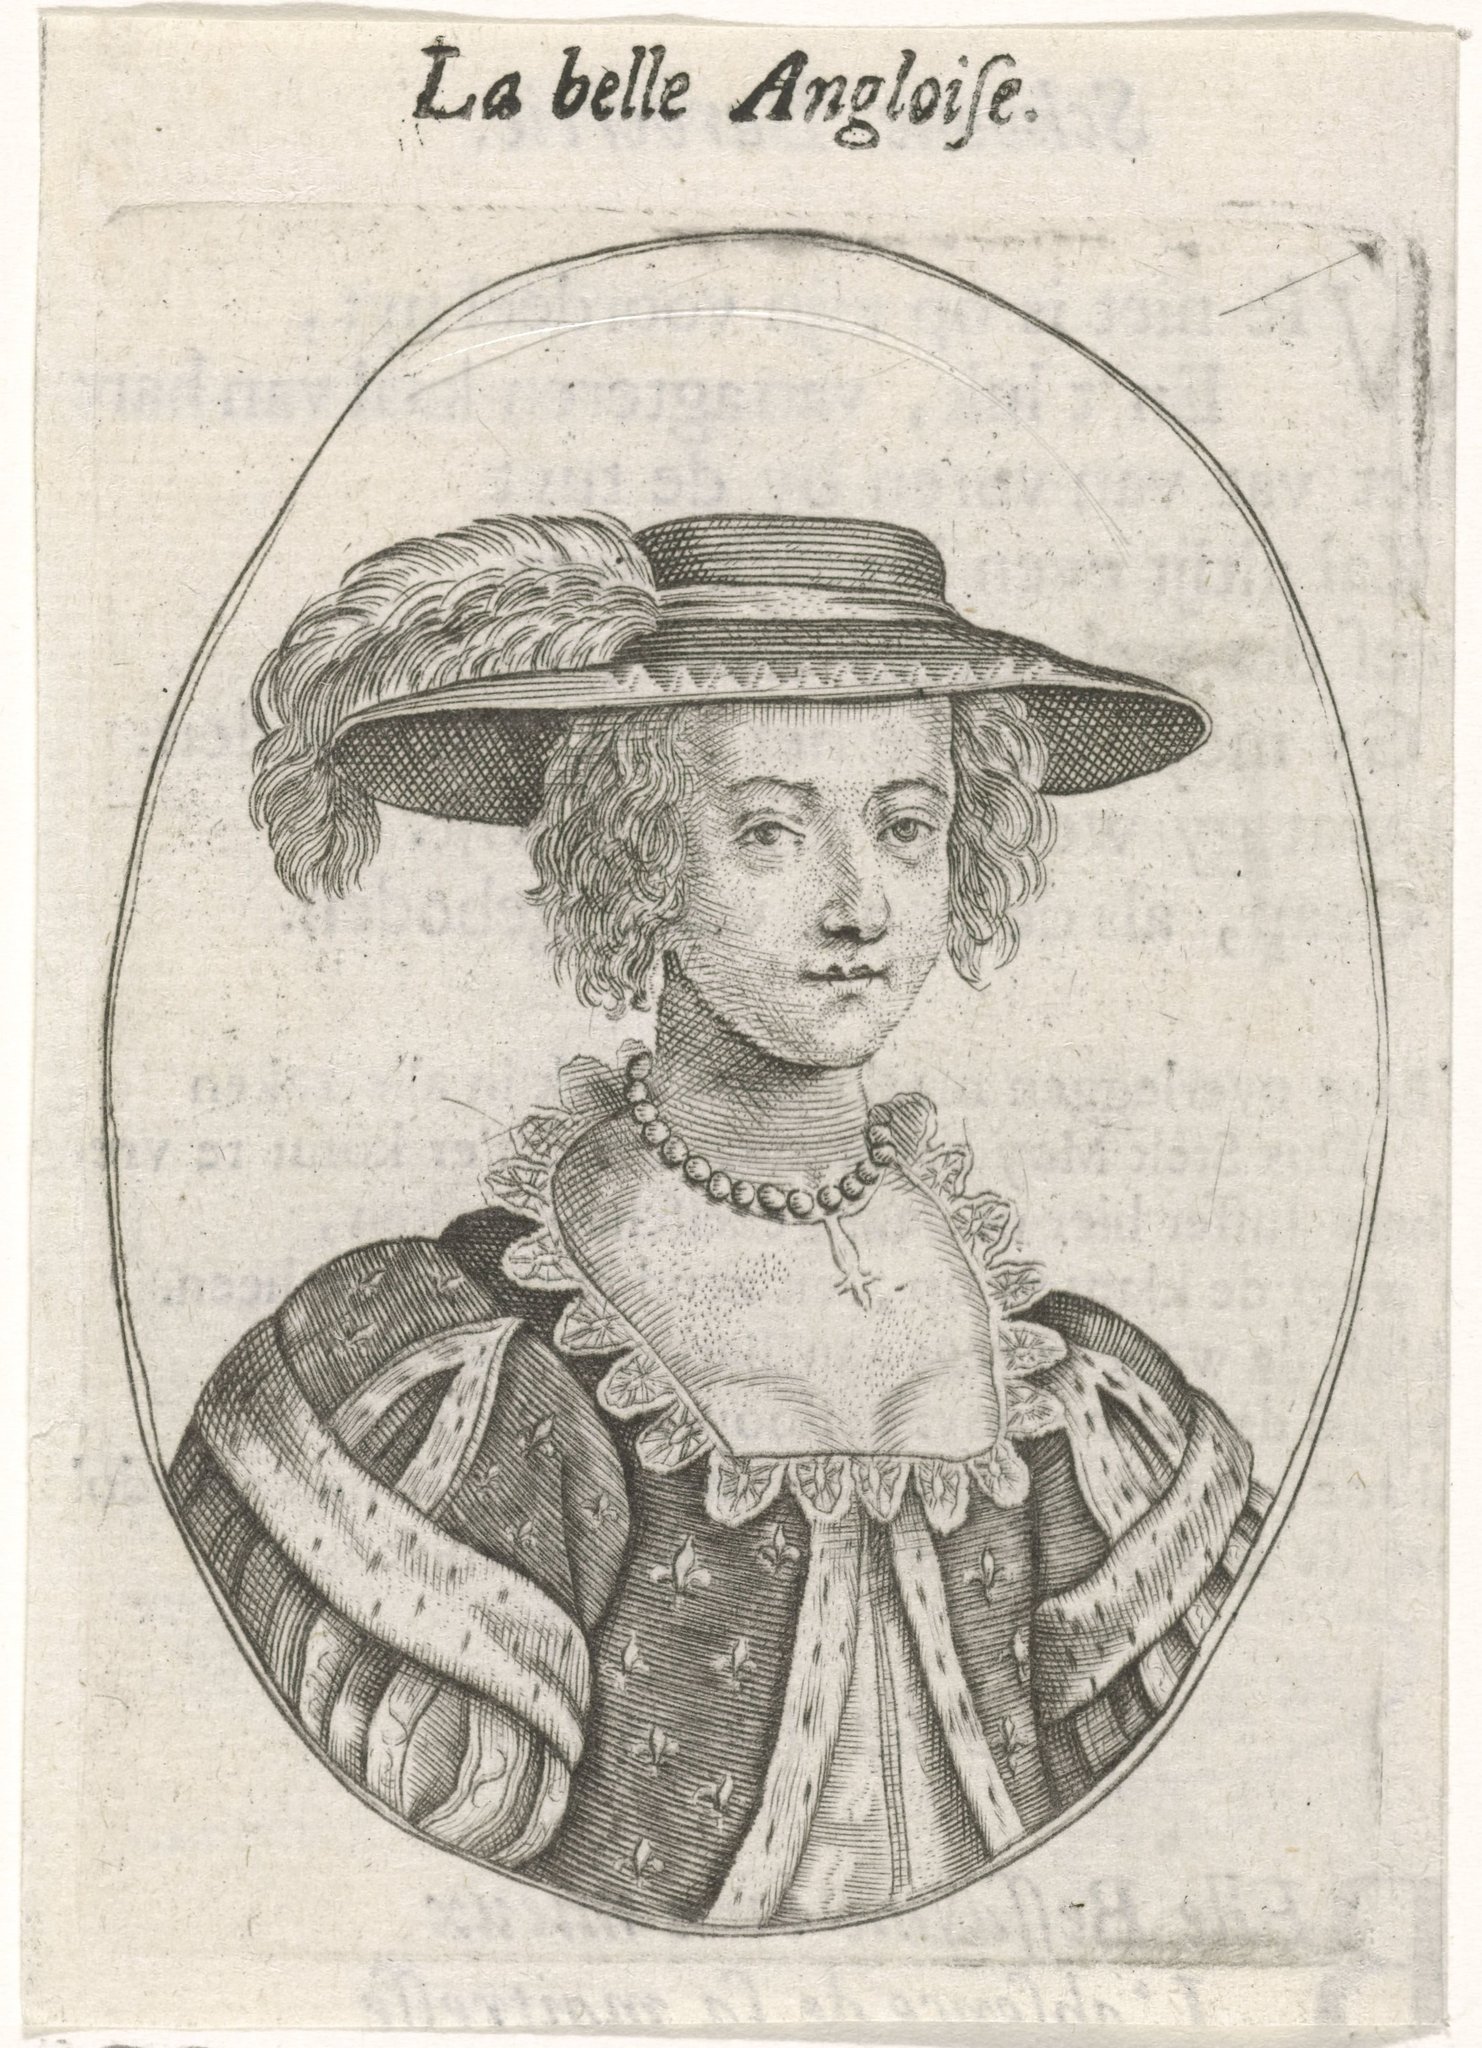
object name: costume print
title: Le miroir des courtisannes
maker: Anonymous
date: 1630-1710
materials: paper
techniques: engraving, letterpress printing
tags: whore, prostitute - cc - male prostitution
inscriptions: collector's mark: Lugt 2228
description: Prent gemaakt voor: Le miroir des courtisannes de ce temps. Verschillende edities van dit werk, uitgegeven tussen 1630 en 1710, maken gebruik van de gravures van Van der Passe óf van spiegelbeeldige kopieën ervan.